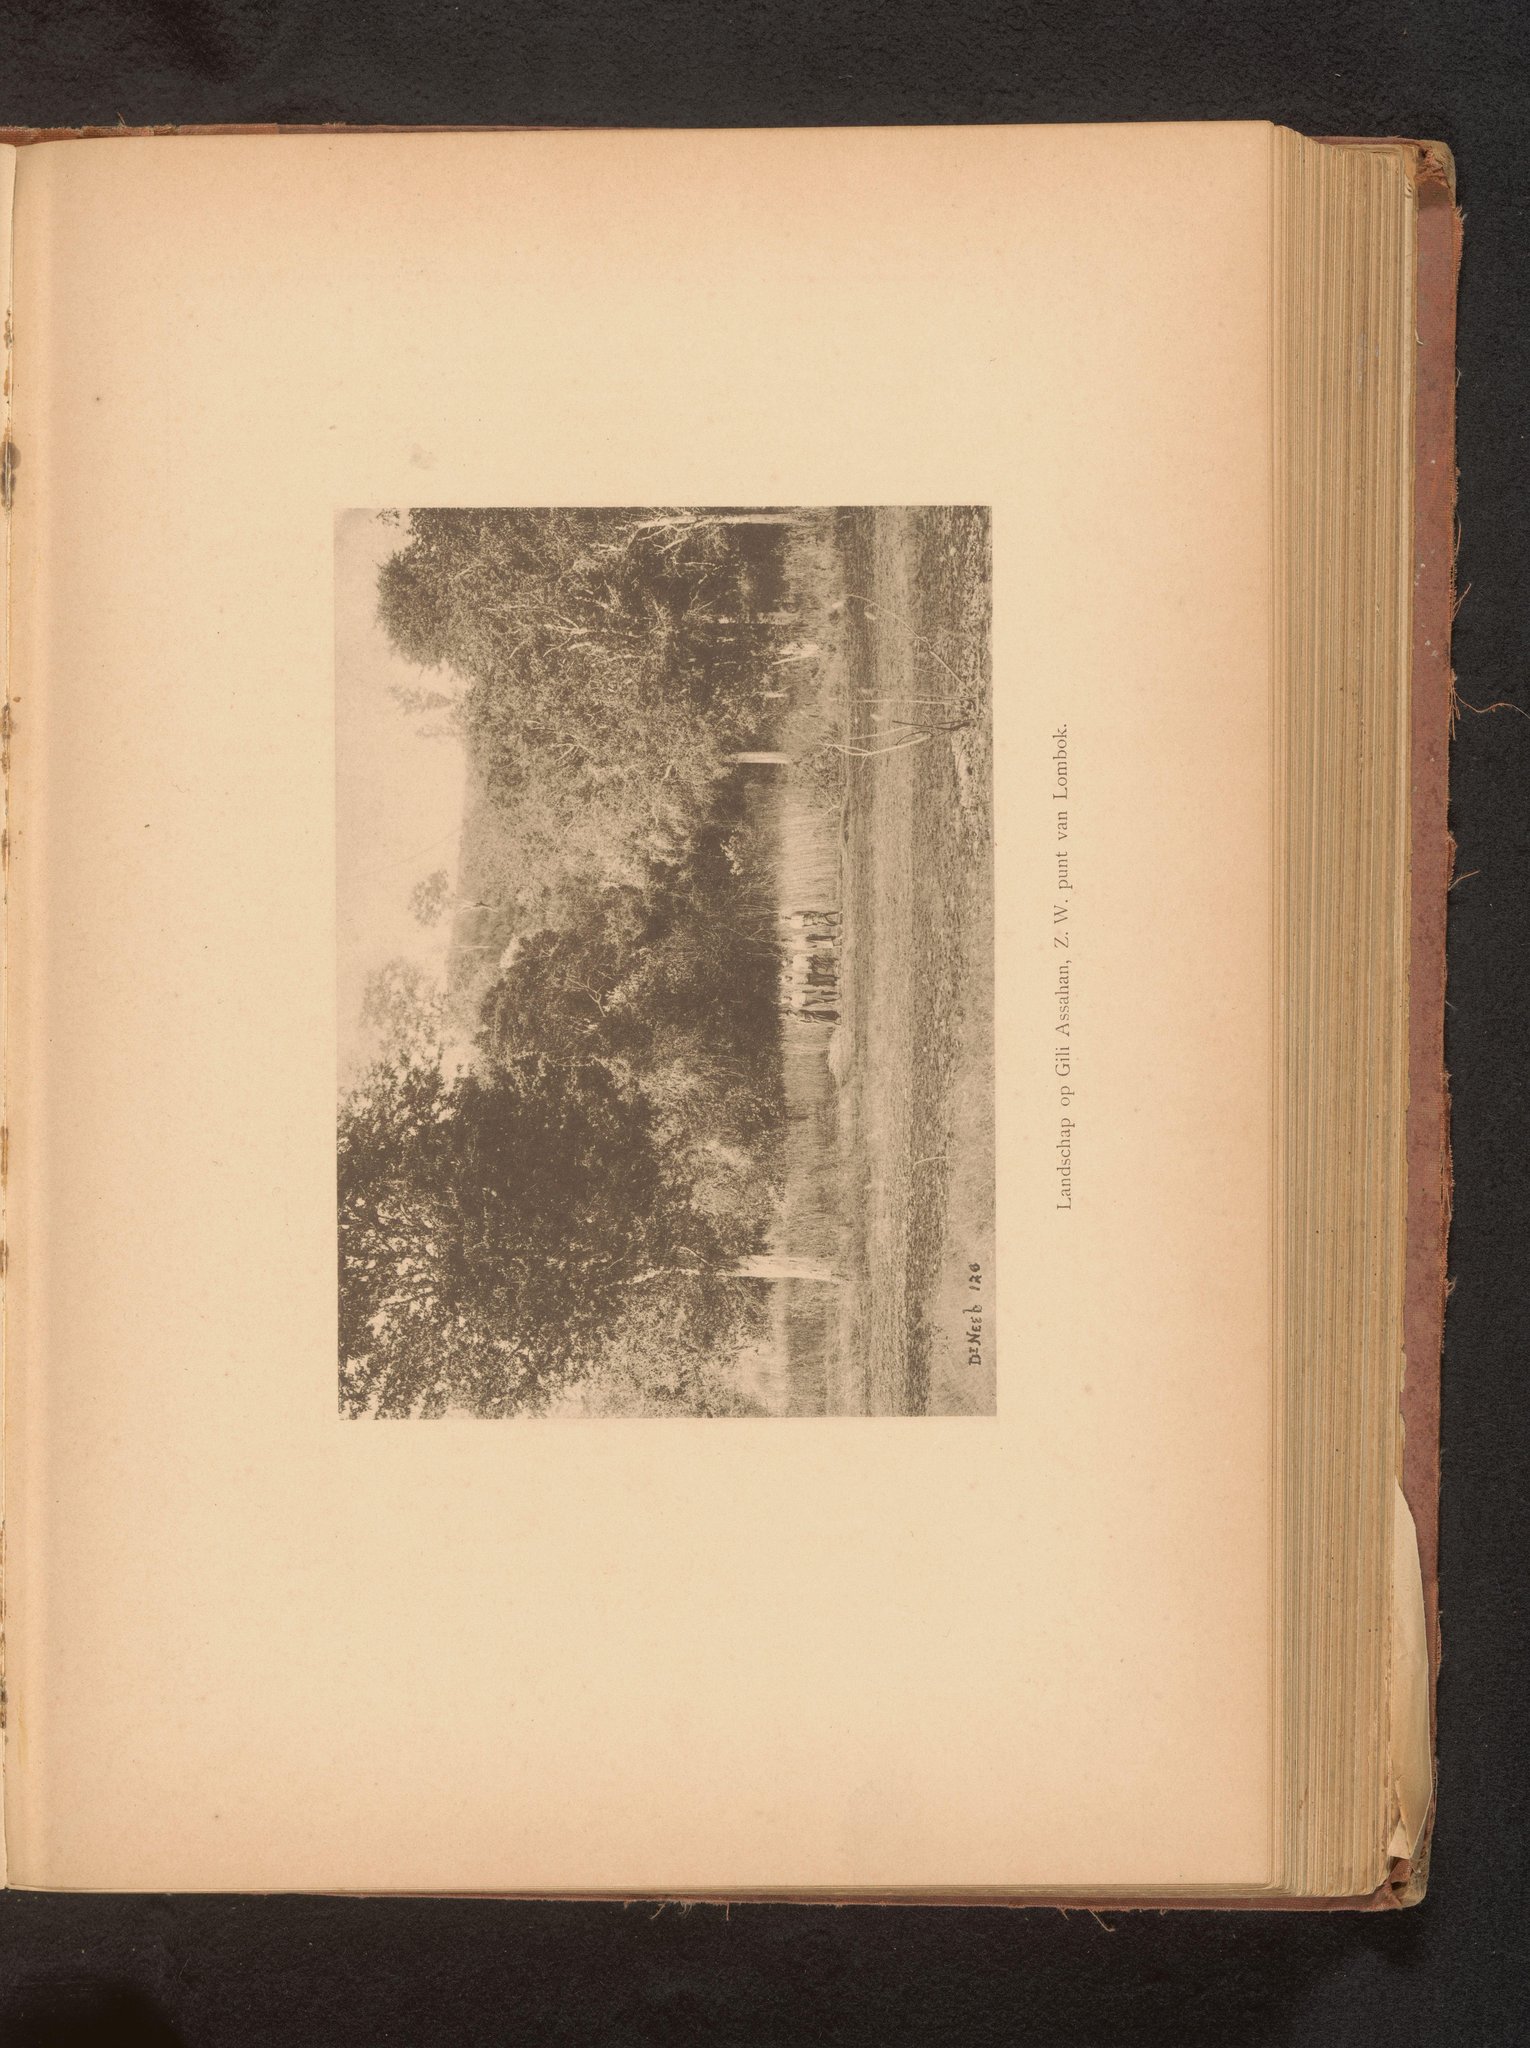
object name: page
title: Landschap op Gli Assahan, Z. W. punt van Lombook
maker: christiaan johan neeb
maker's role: arts, fotograaf, officier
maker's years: 1860-1925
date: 1892-1897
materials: paper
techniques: photograph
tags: trees, landscapes, anonymous historical persons portrayed in a group, in a group-portrait